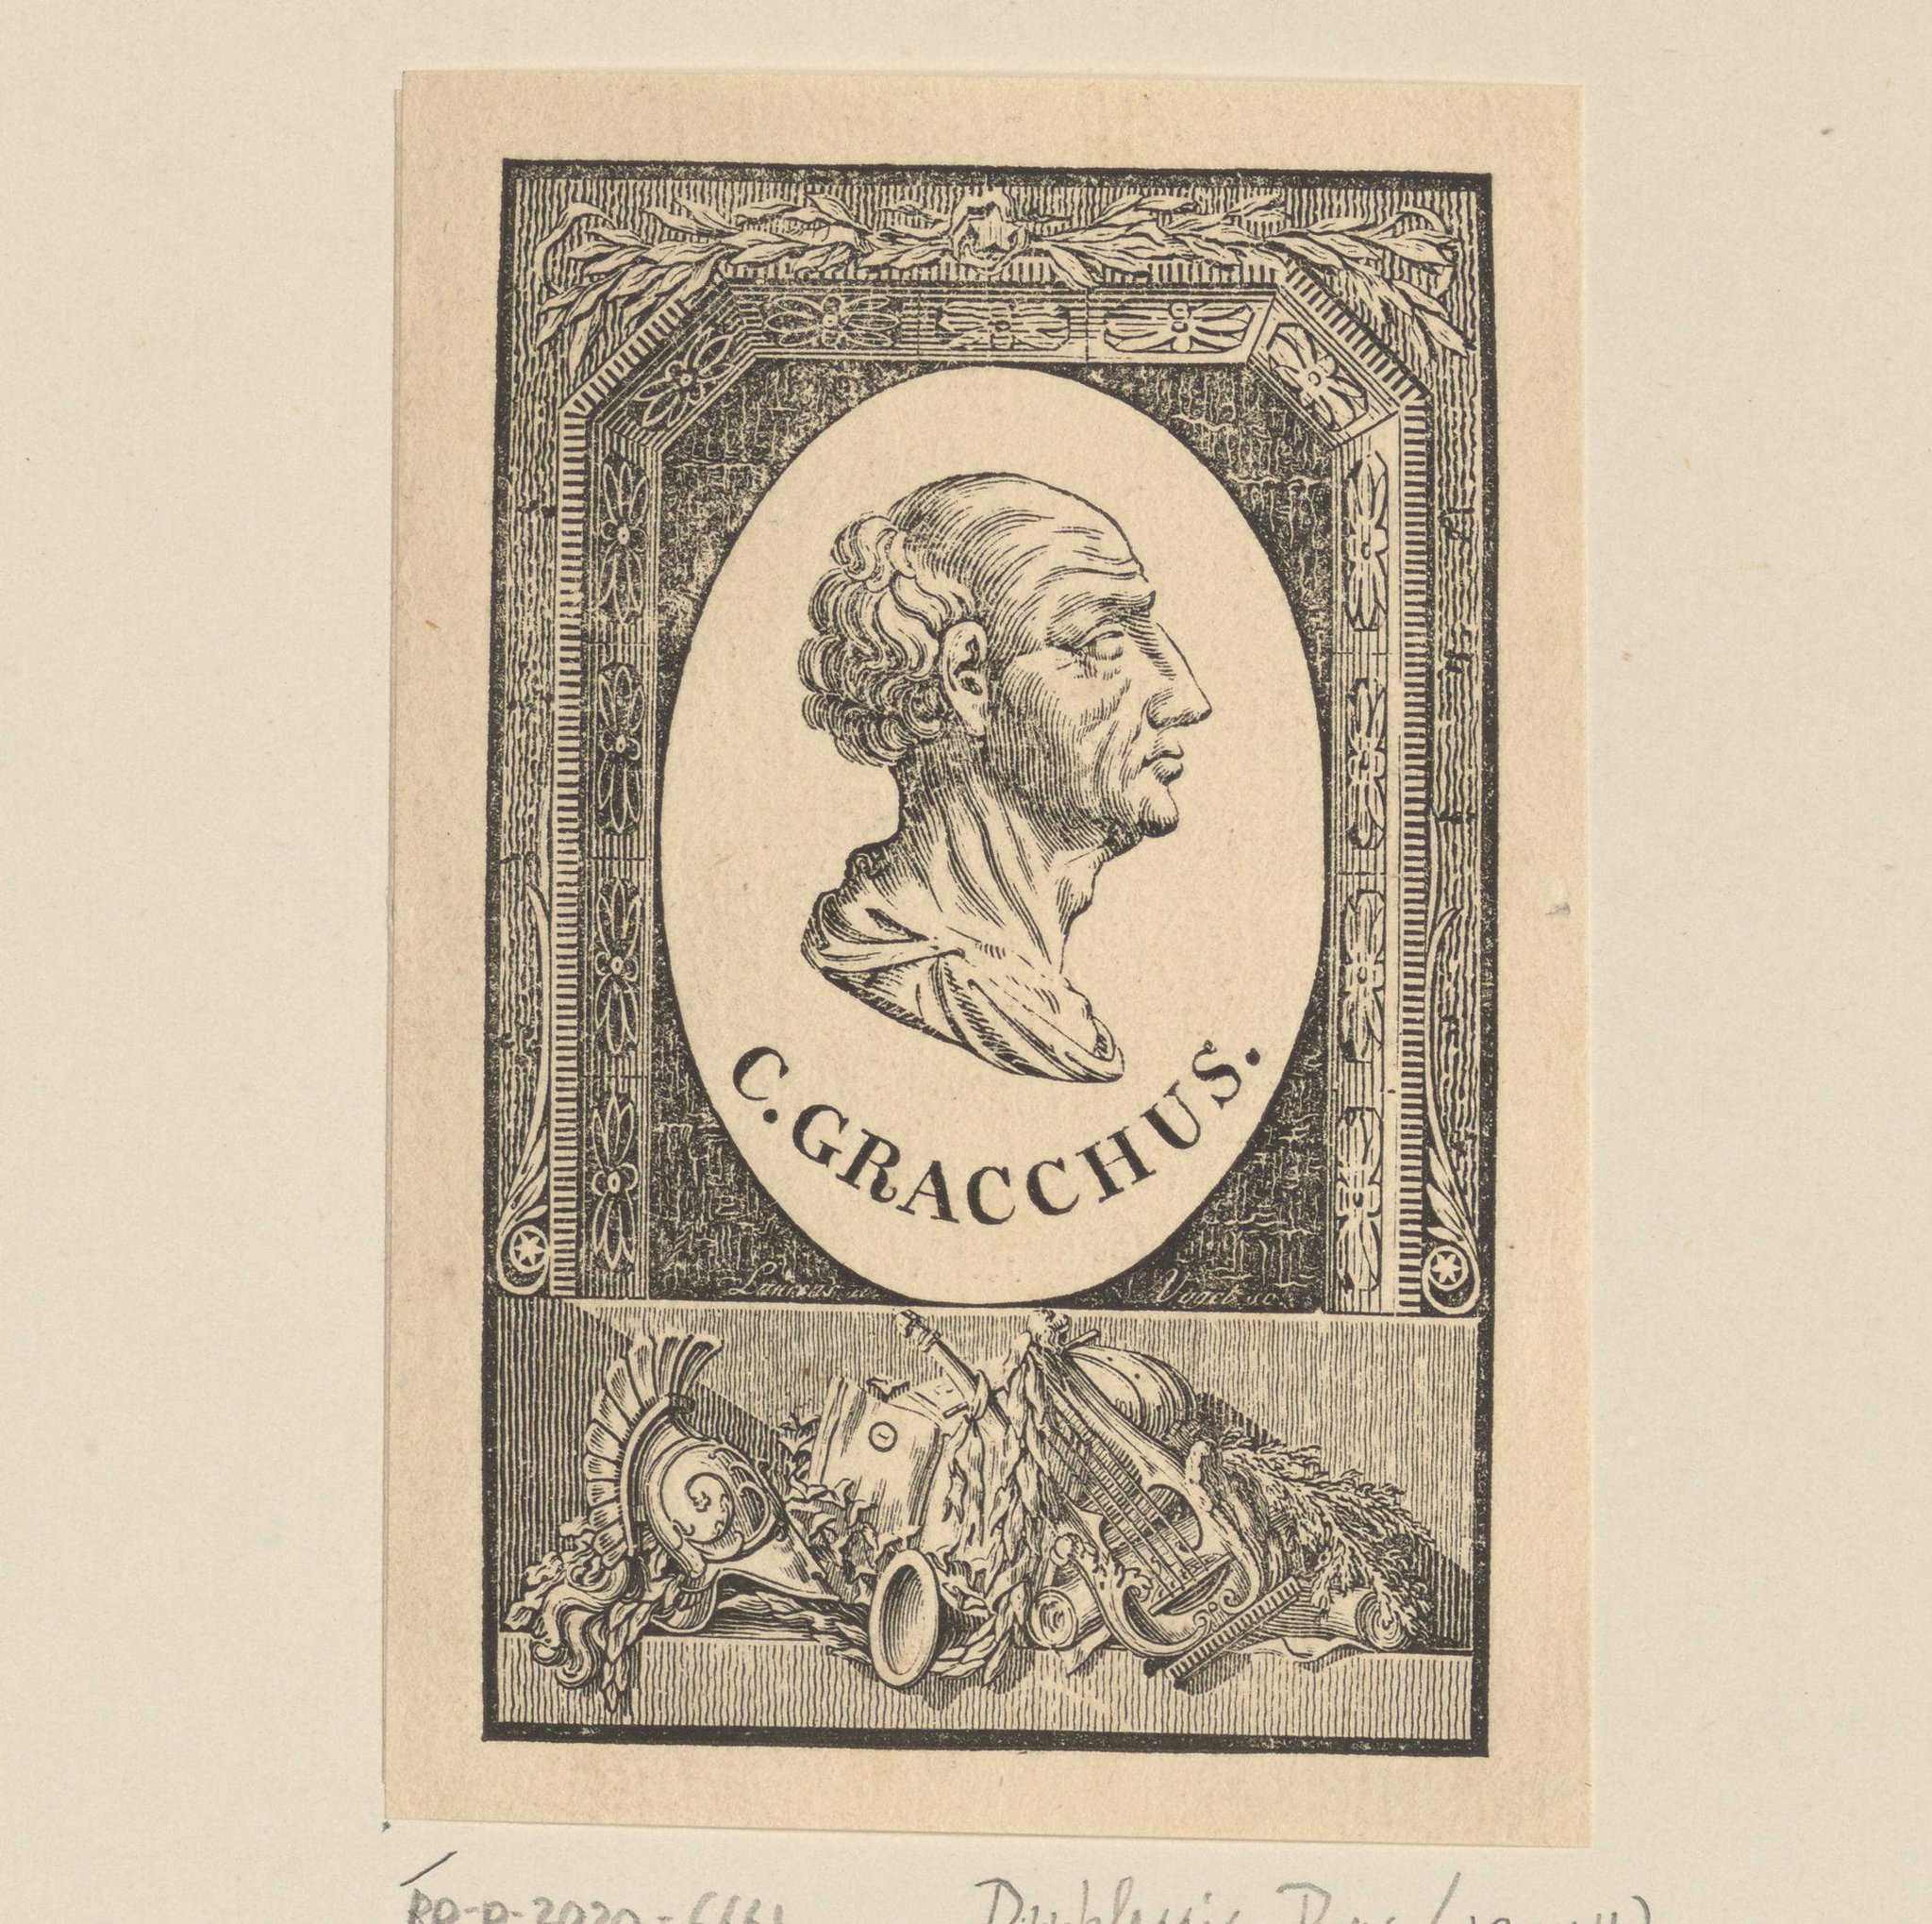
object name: print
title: Portret van Gaius Gracchus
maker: laurent vogel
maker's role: print maker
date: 1820-1920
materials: paper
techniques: engraving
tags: politician, theologian, historical persons